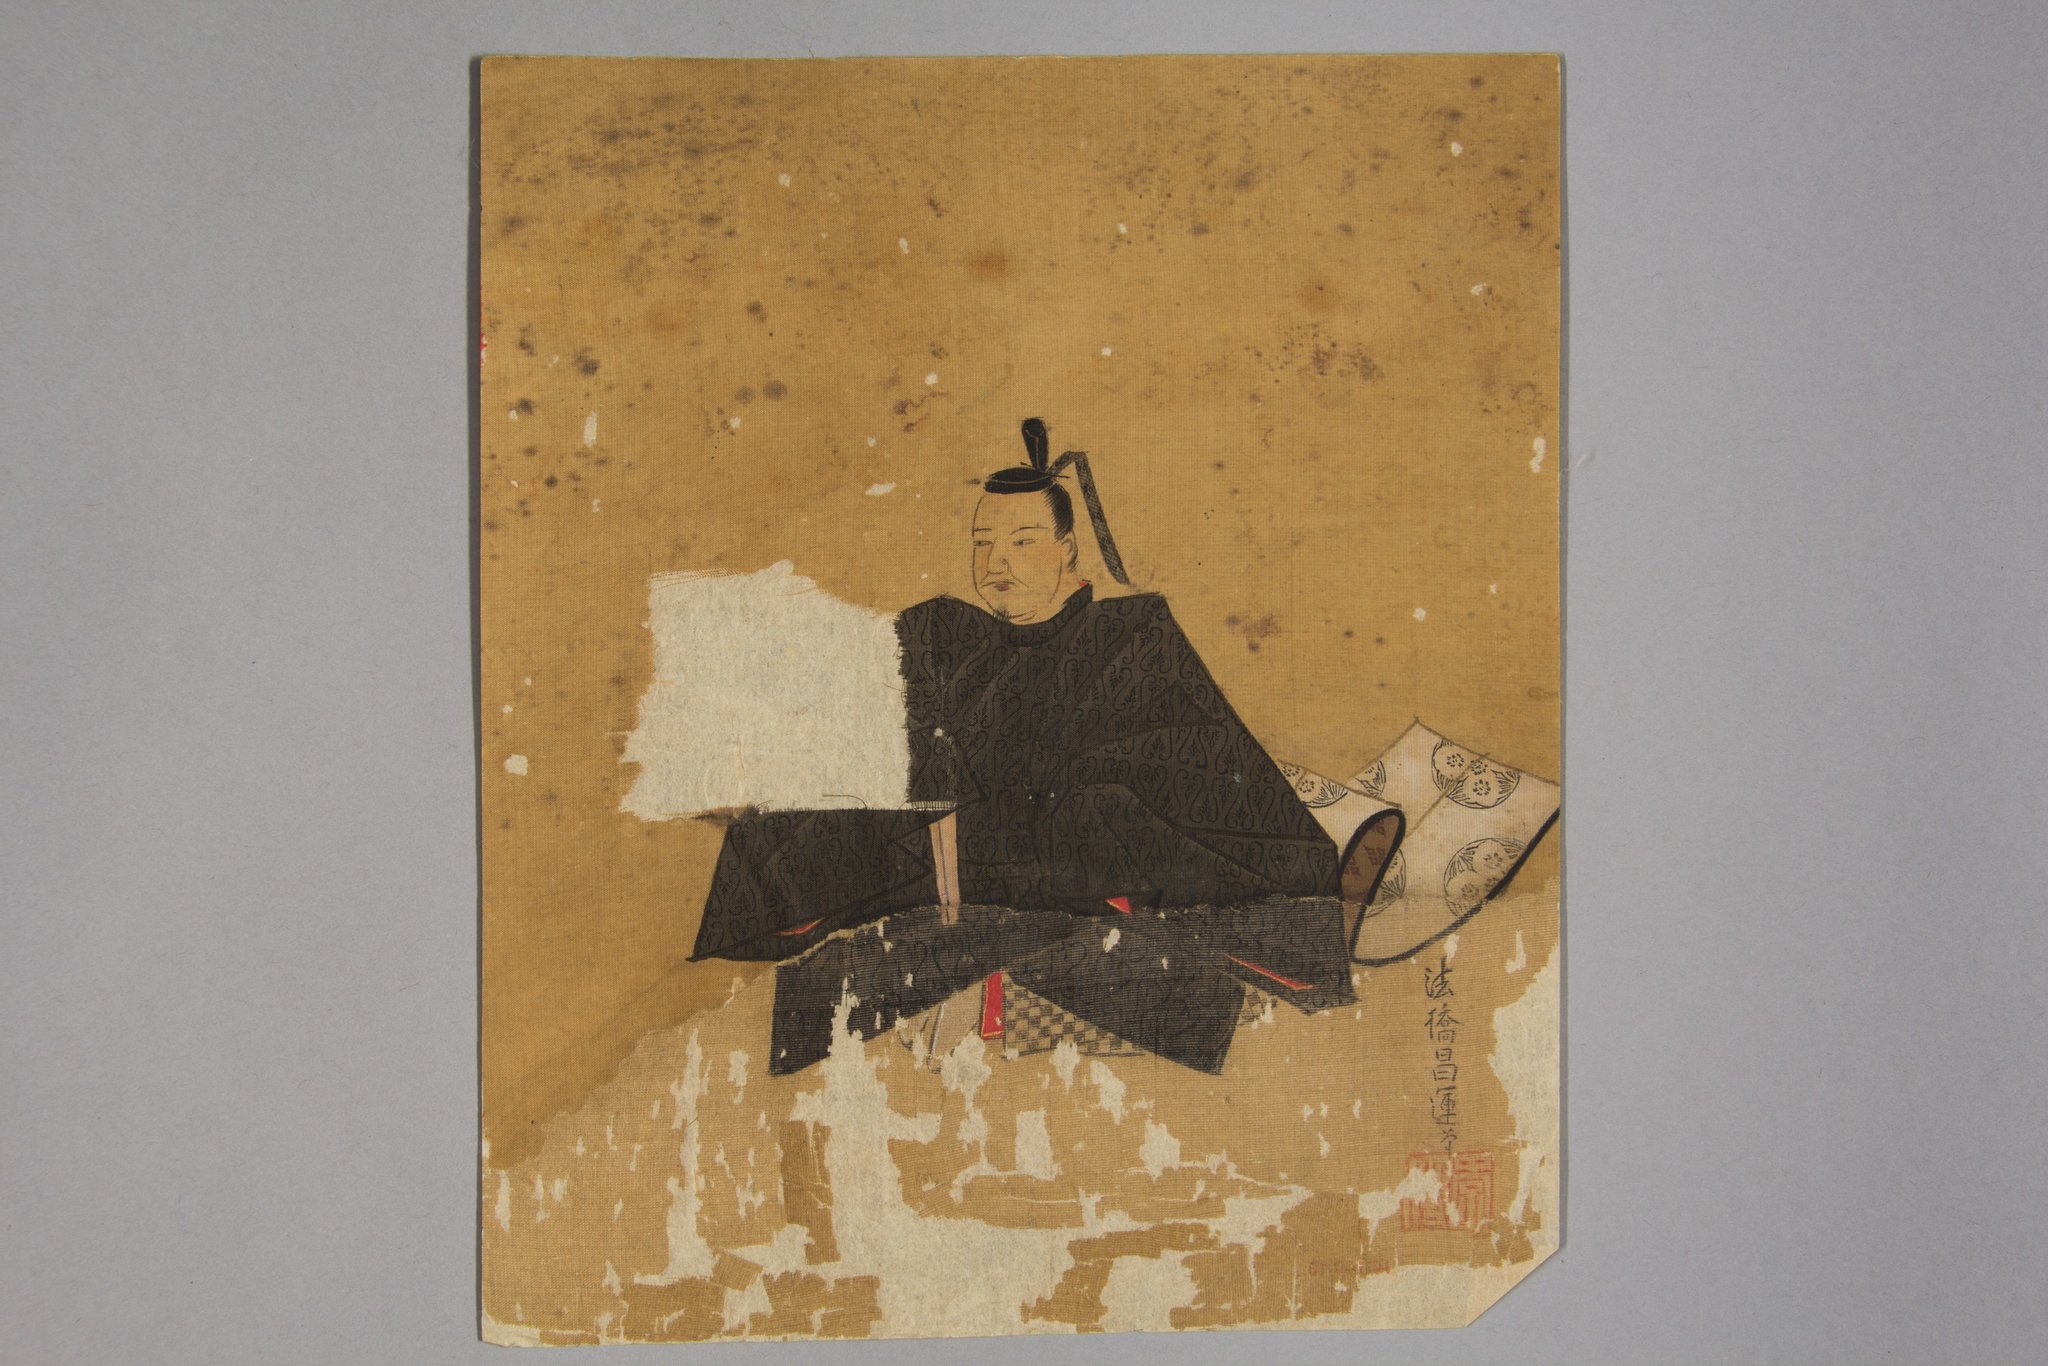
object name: painting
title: Immortal Poet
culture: japanese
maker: kano shōun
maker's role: artist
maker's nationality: japanese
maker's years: 1637-1702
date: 1601-1700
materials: ink, silk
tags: men,poets